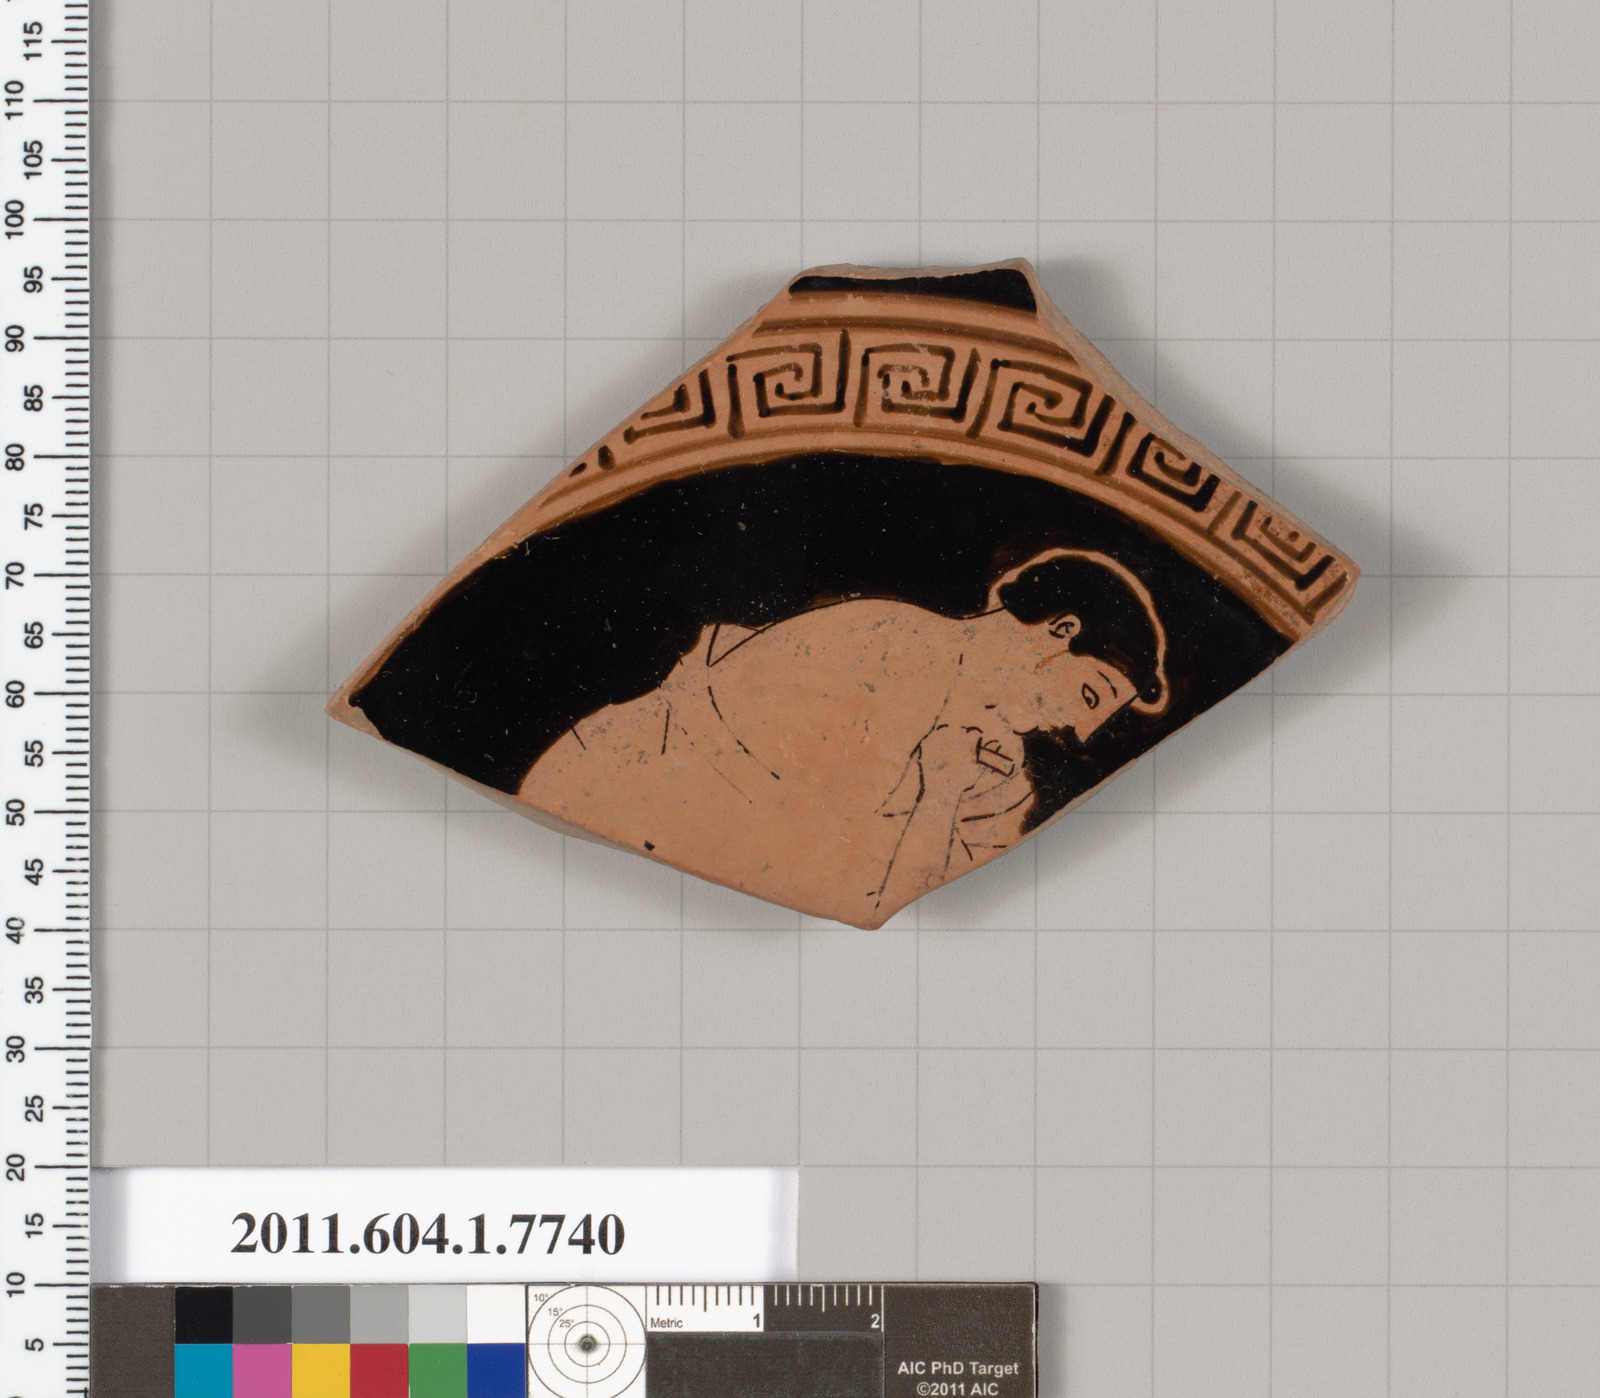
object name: kylix fragment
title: Terracotta fragment of a kylix (drinking cup)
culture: greek, attic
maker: boot painter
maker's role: artist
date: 480-470 BCE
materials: terracotta